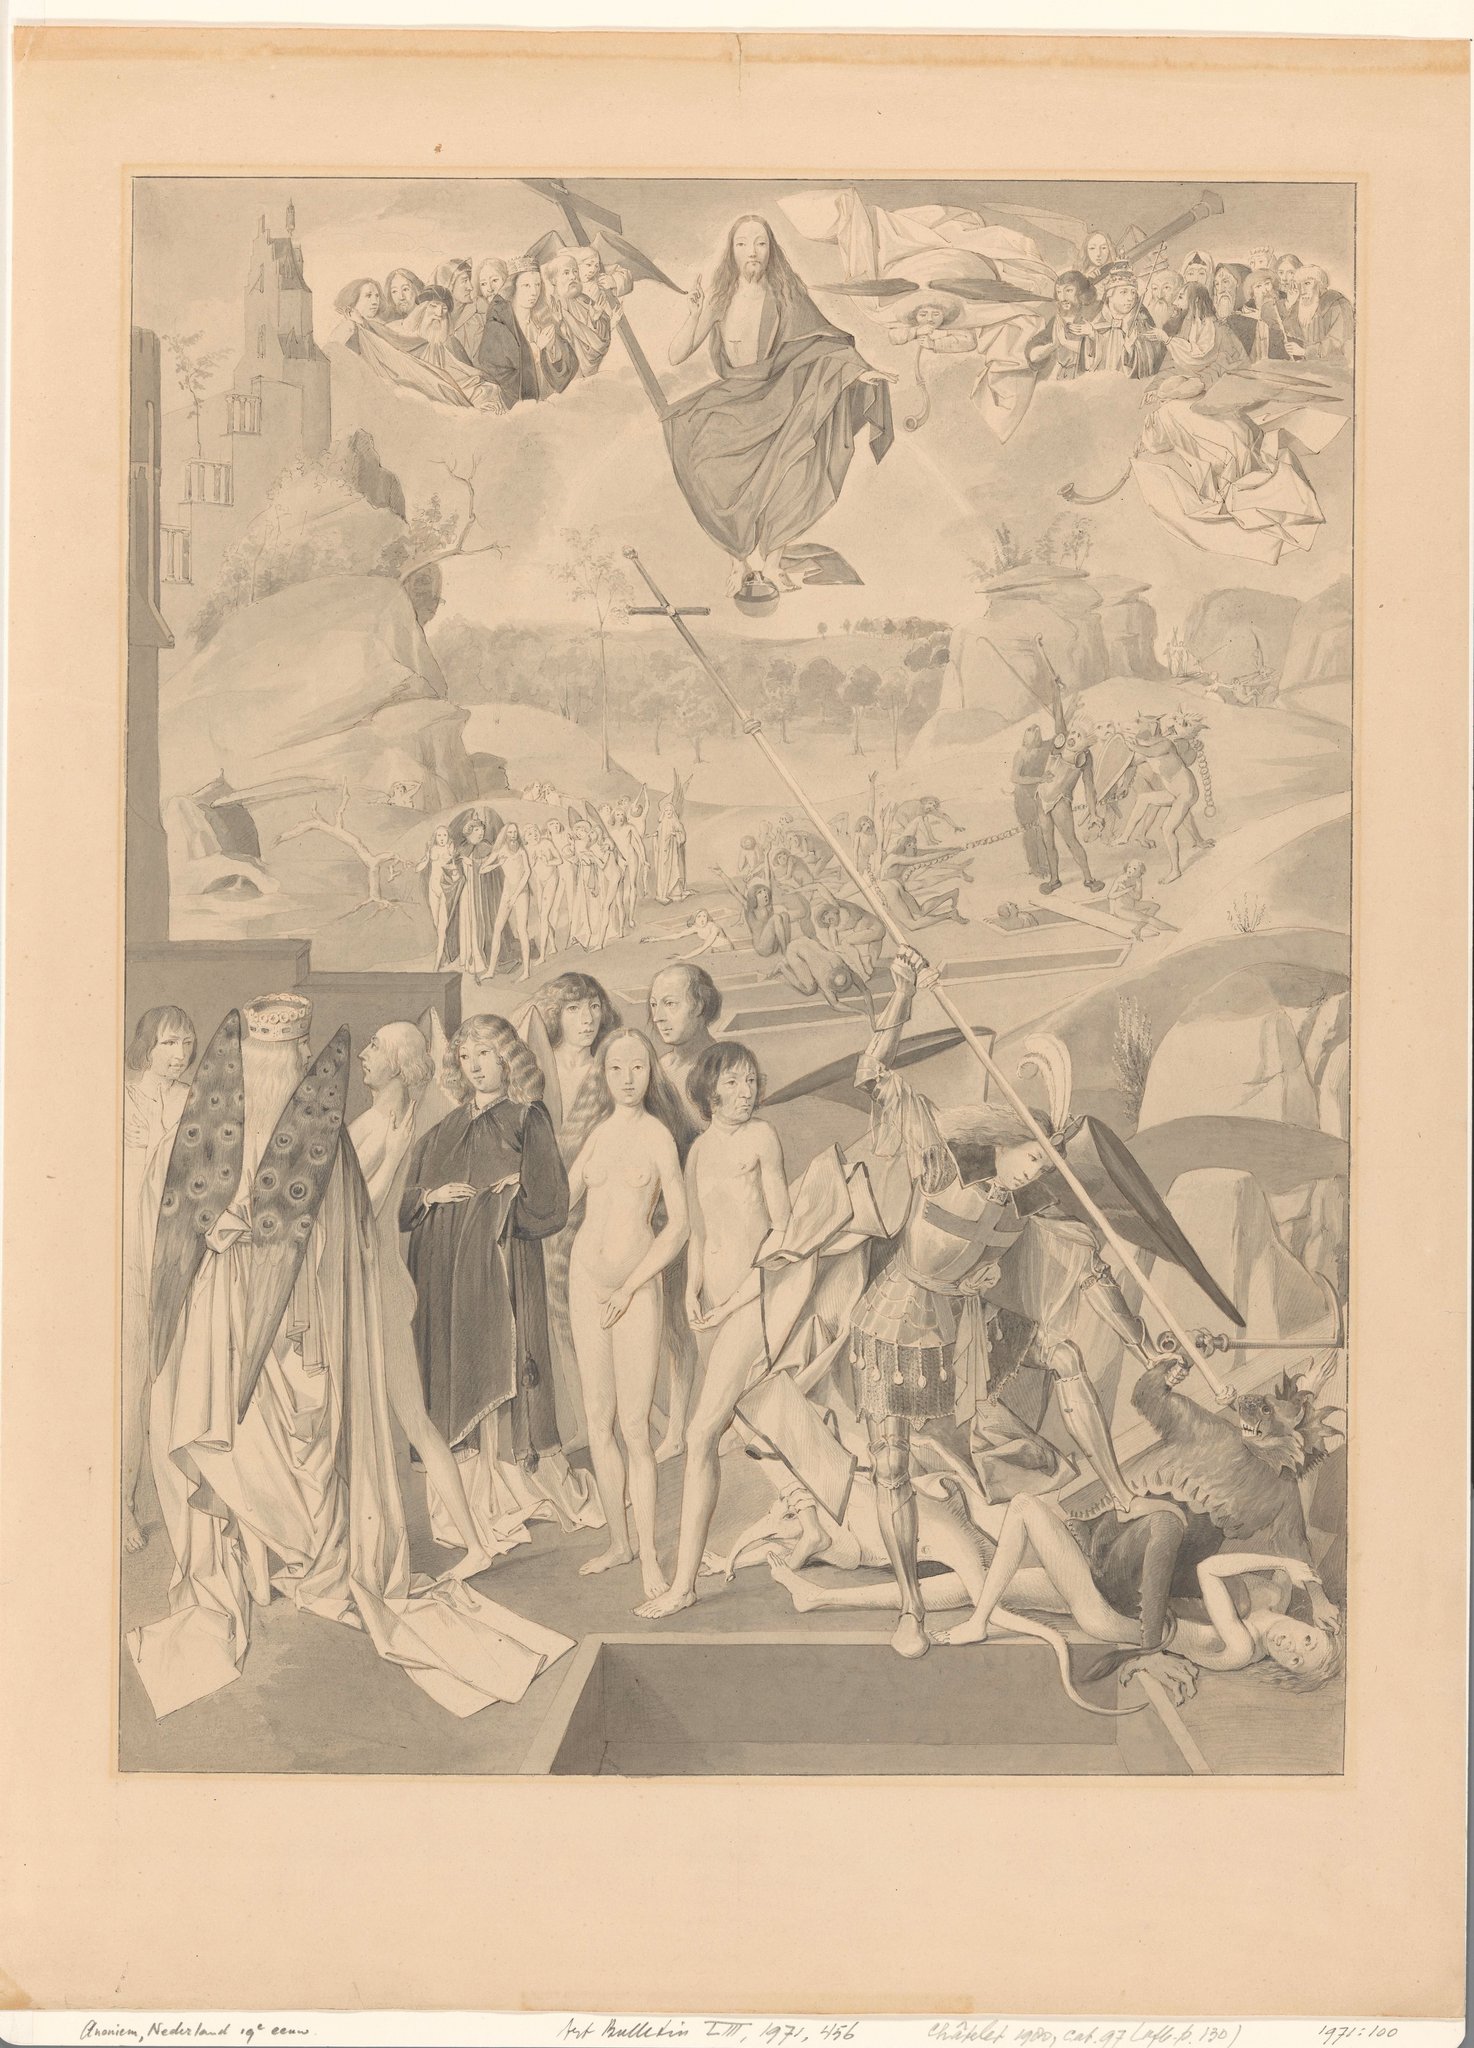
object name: drawing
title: Middenpaneel van een drieluik: laatste oordeel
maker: Anonymous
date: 1800-1900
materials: ink, paper, pencil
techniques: brush, pen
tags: representation of last judgement, with the archangel michael weighing the souls (or dividing the blessed and the damned) (+ donor(s), supplicant(s), whether or not with patron saint(s))